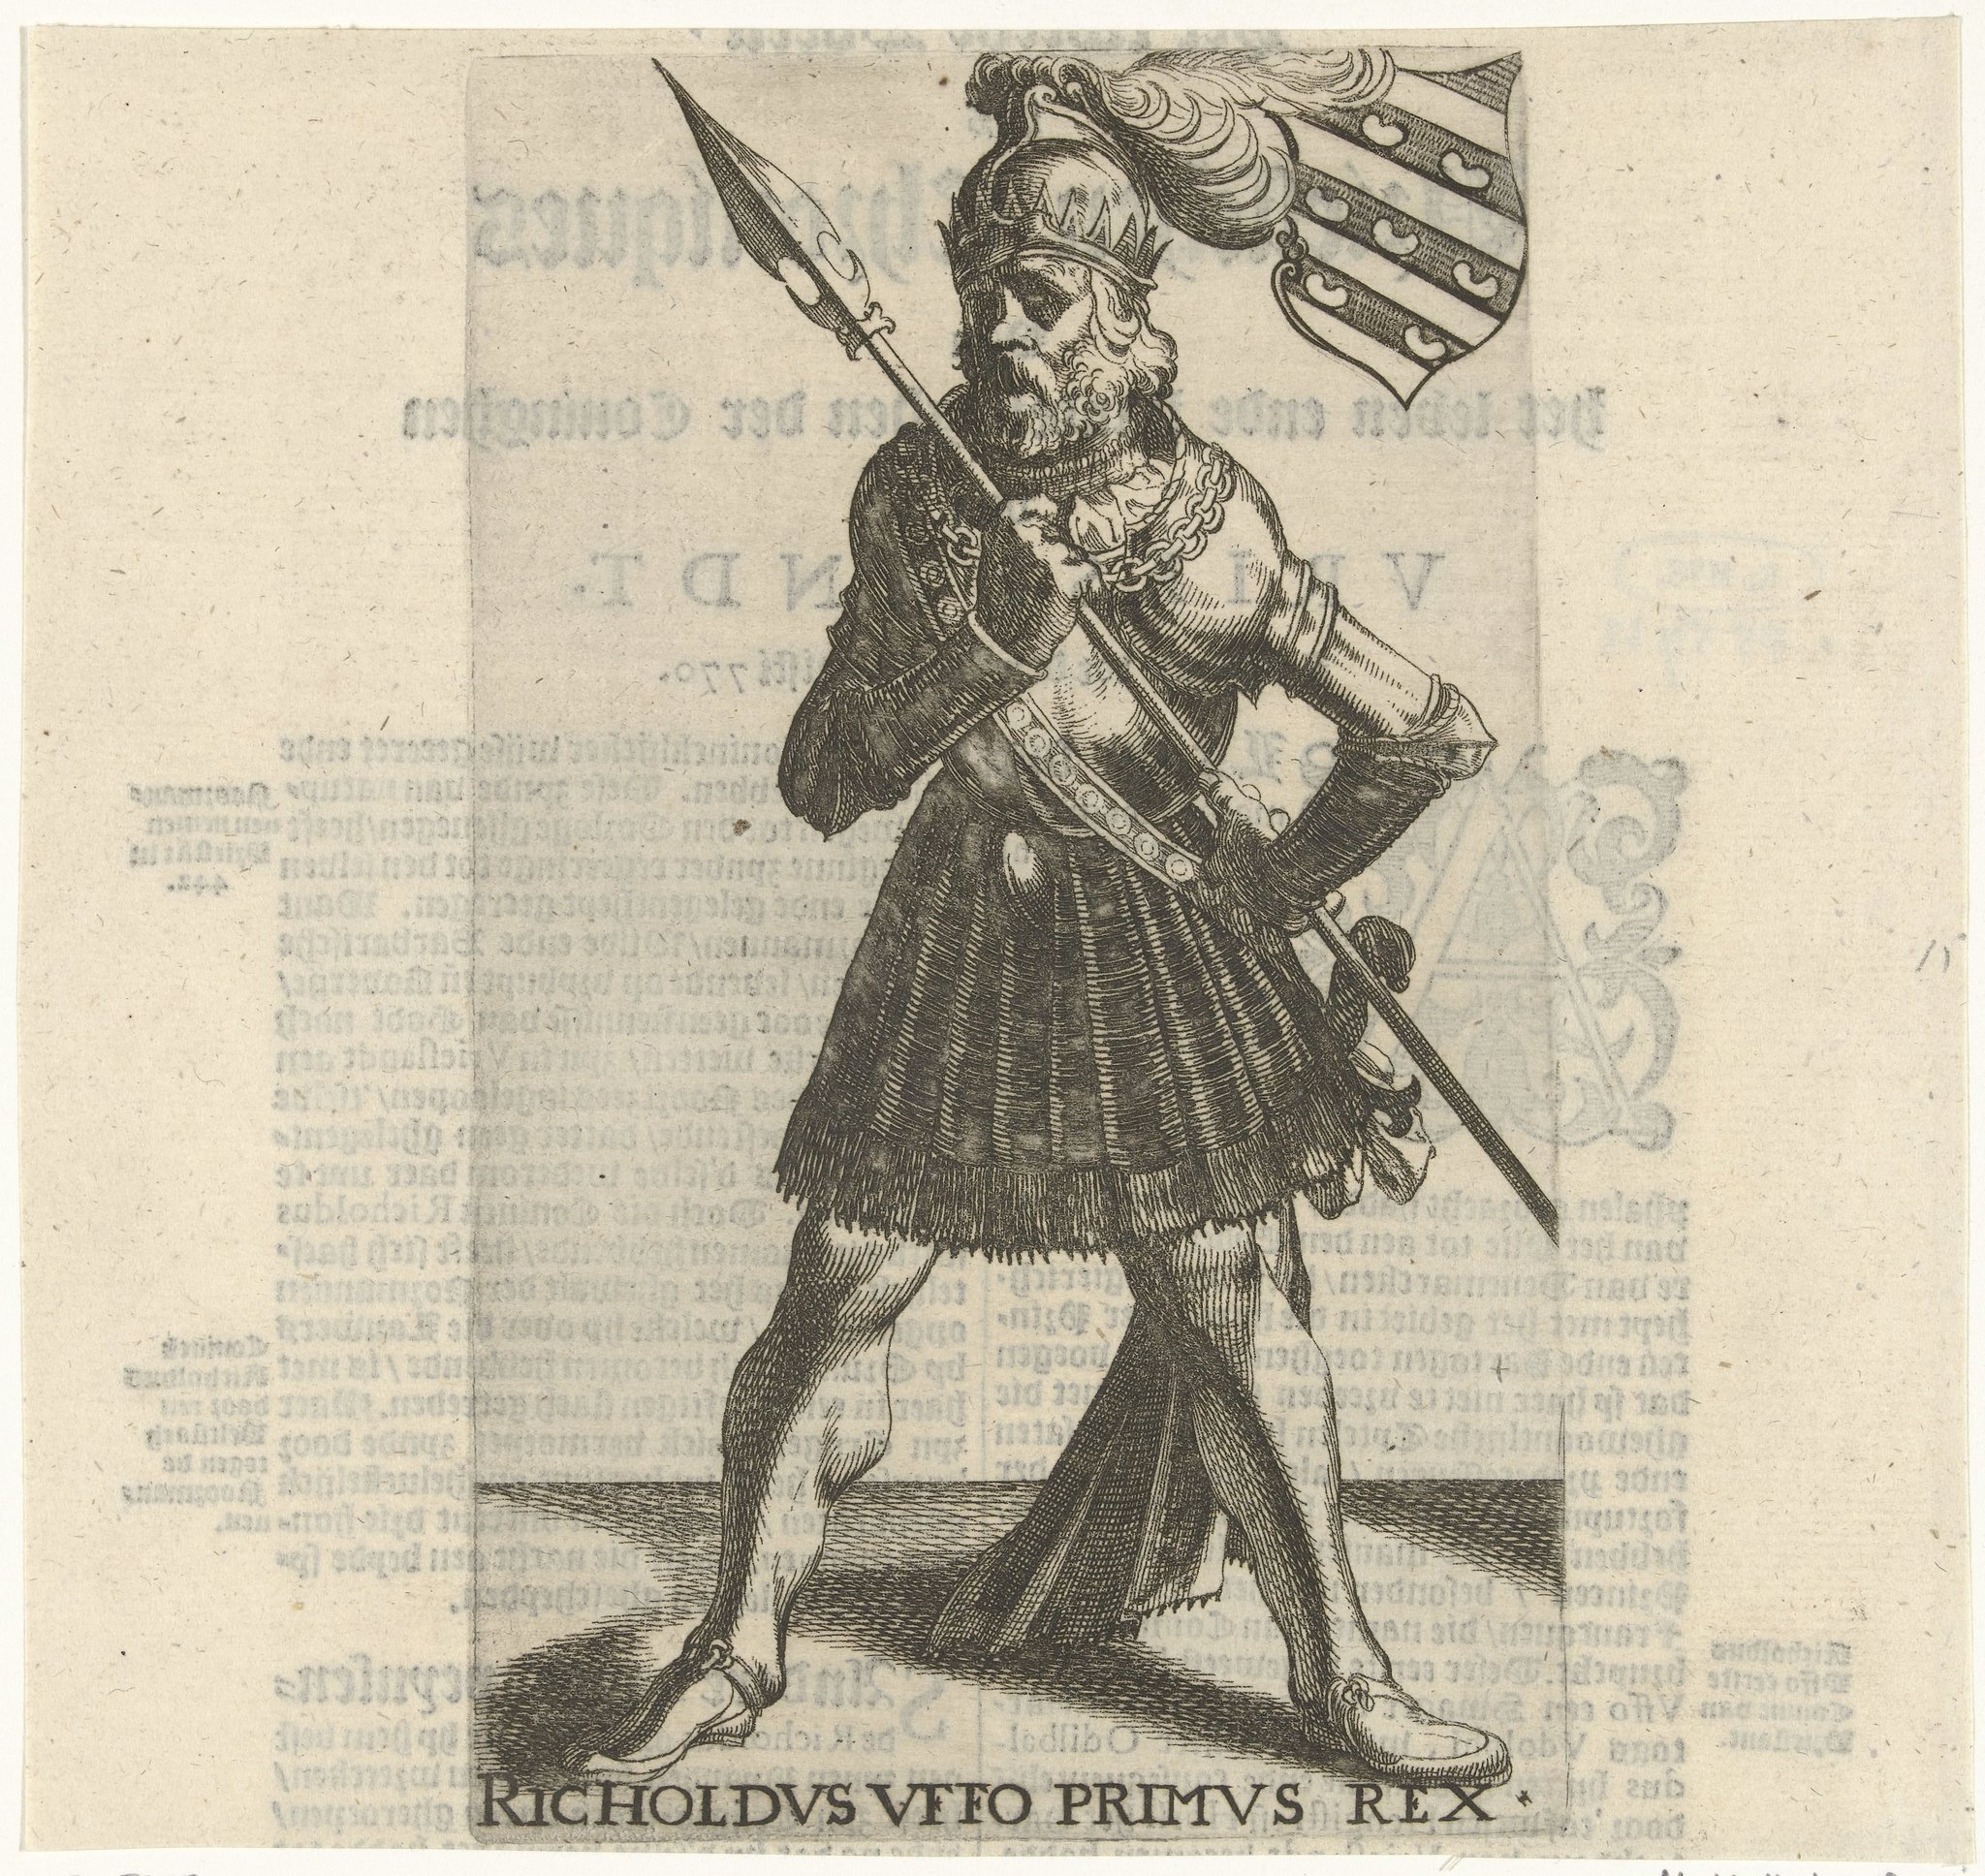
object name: print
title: Friese heersers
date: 1622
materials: paper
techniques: etching, letterpress printing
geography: franeker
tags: richold ii (koning der friezen)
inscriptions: collector's mark: Lugt 2228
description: De prent is ook als boekillustratie gebruikt in: Winsemius, P.W. Chronique ofte Historische geschiedenisse van Vrieslant (...). Franeker: Joannes Lamrinck, 1622.